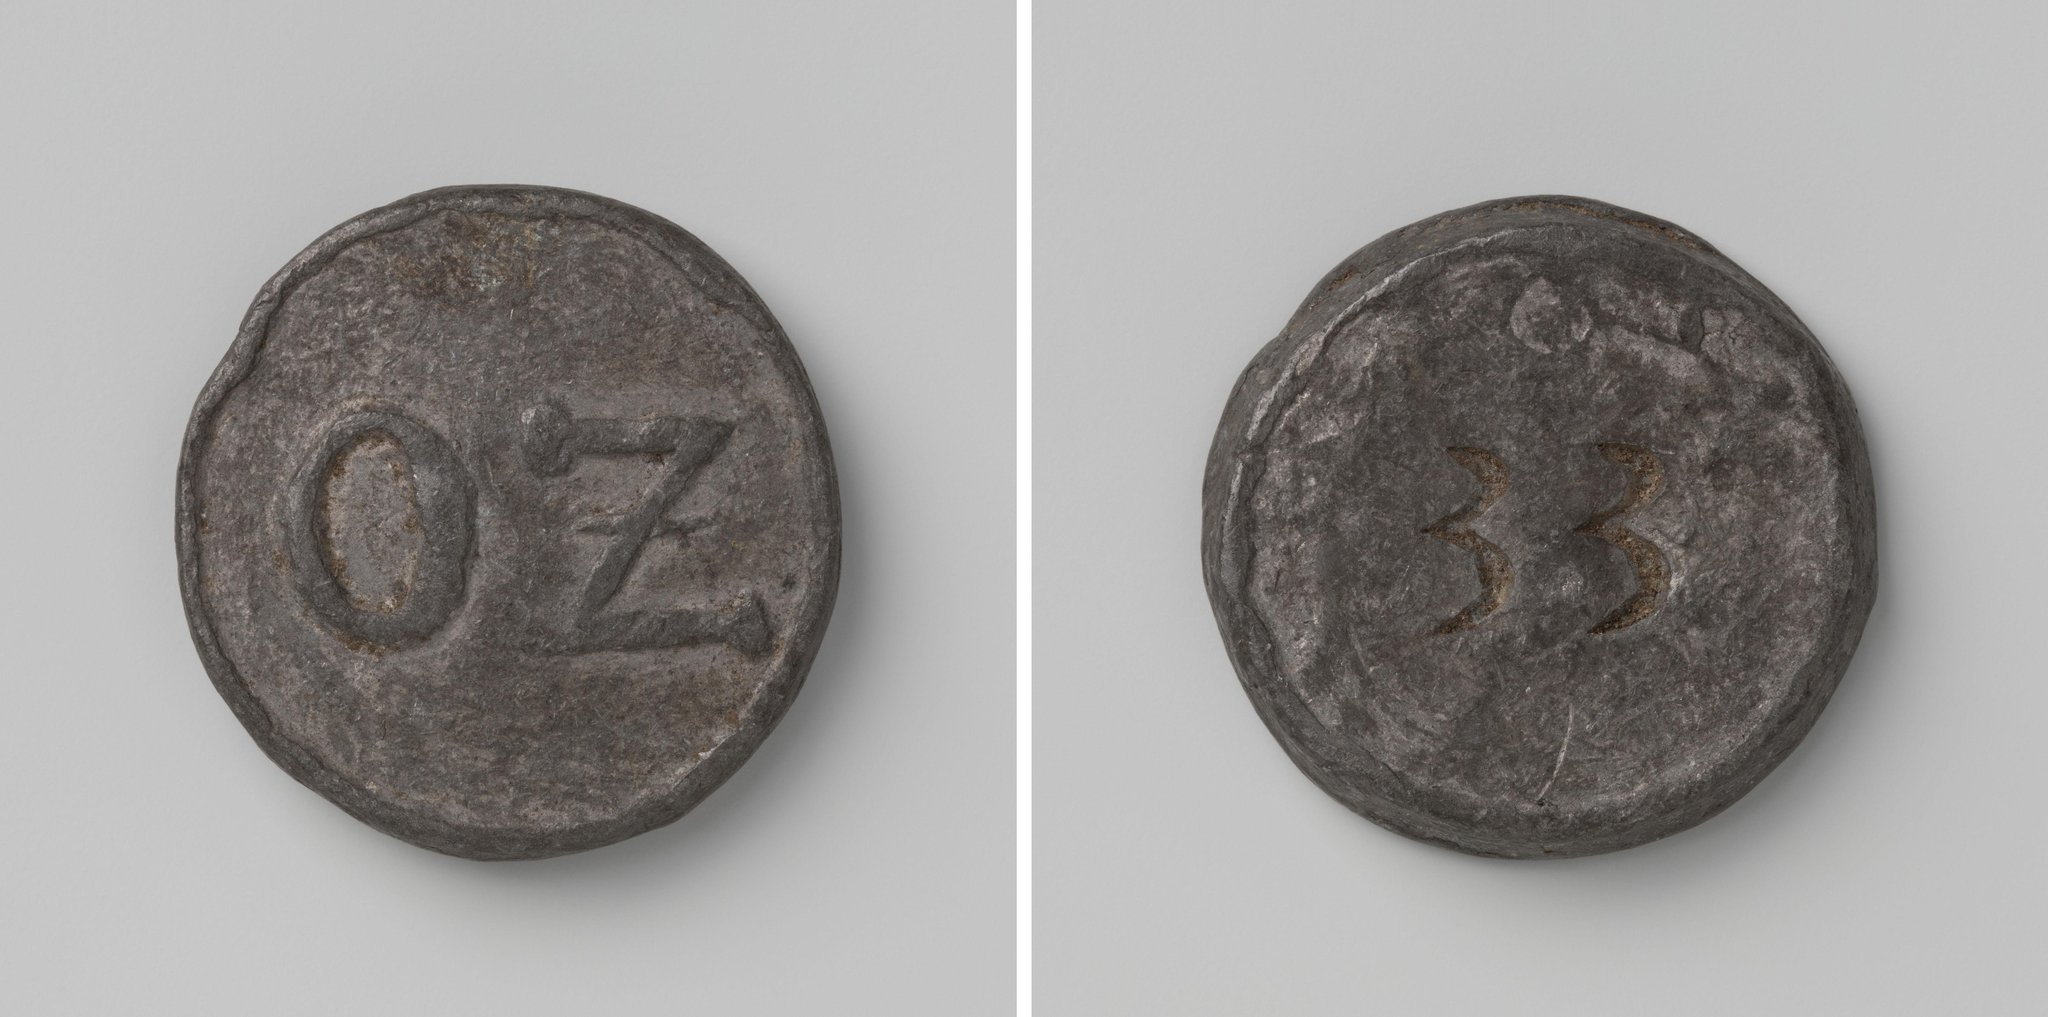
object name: medal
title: Turfdragersgilde van Amsterdam, presentiepenning met O.Z. 33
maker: Anonymous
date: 1600-1800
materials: lead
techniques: casting, engraving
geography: amsterdam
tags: amsterdam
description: Loden penning. Voorzijde: letters O en Z. Keerzijde: cijfer 33